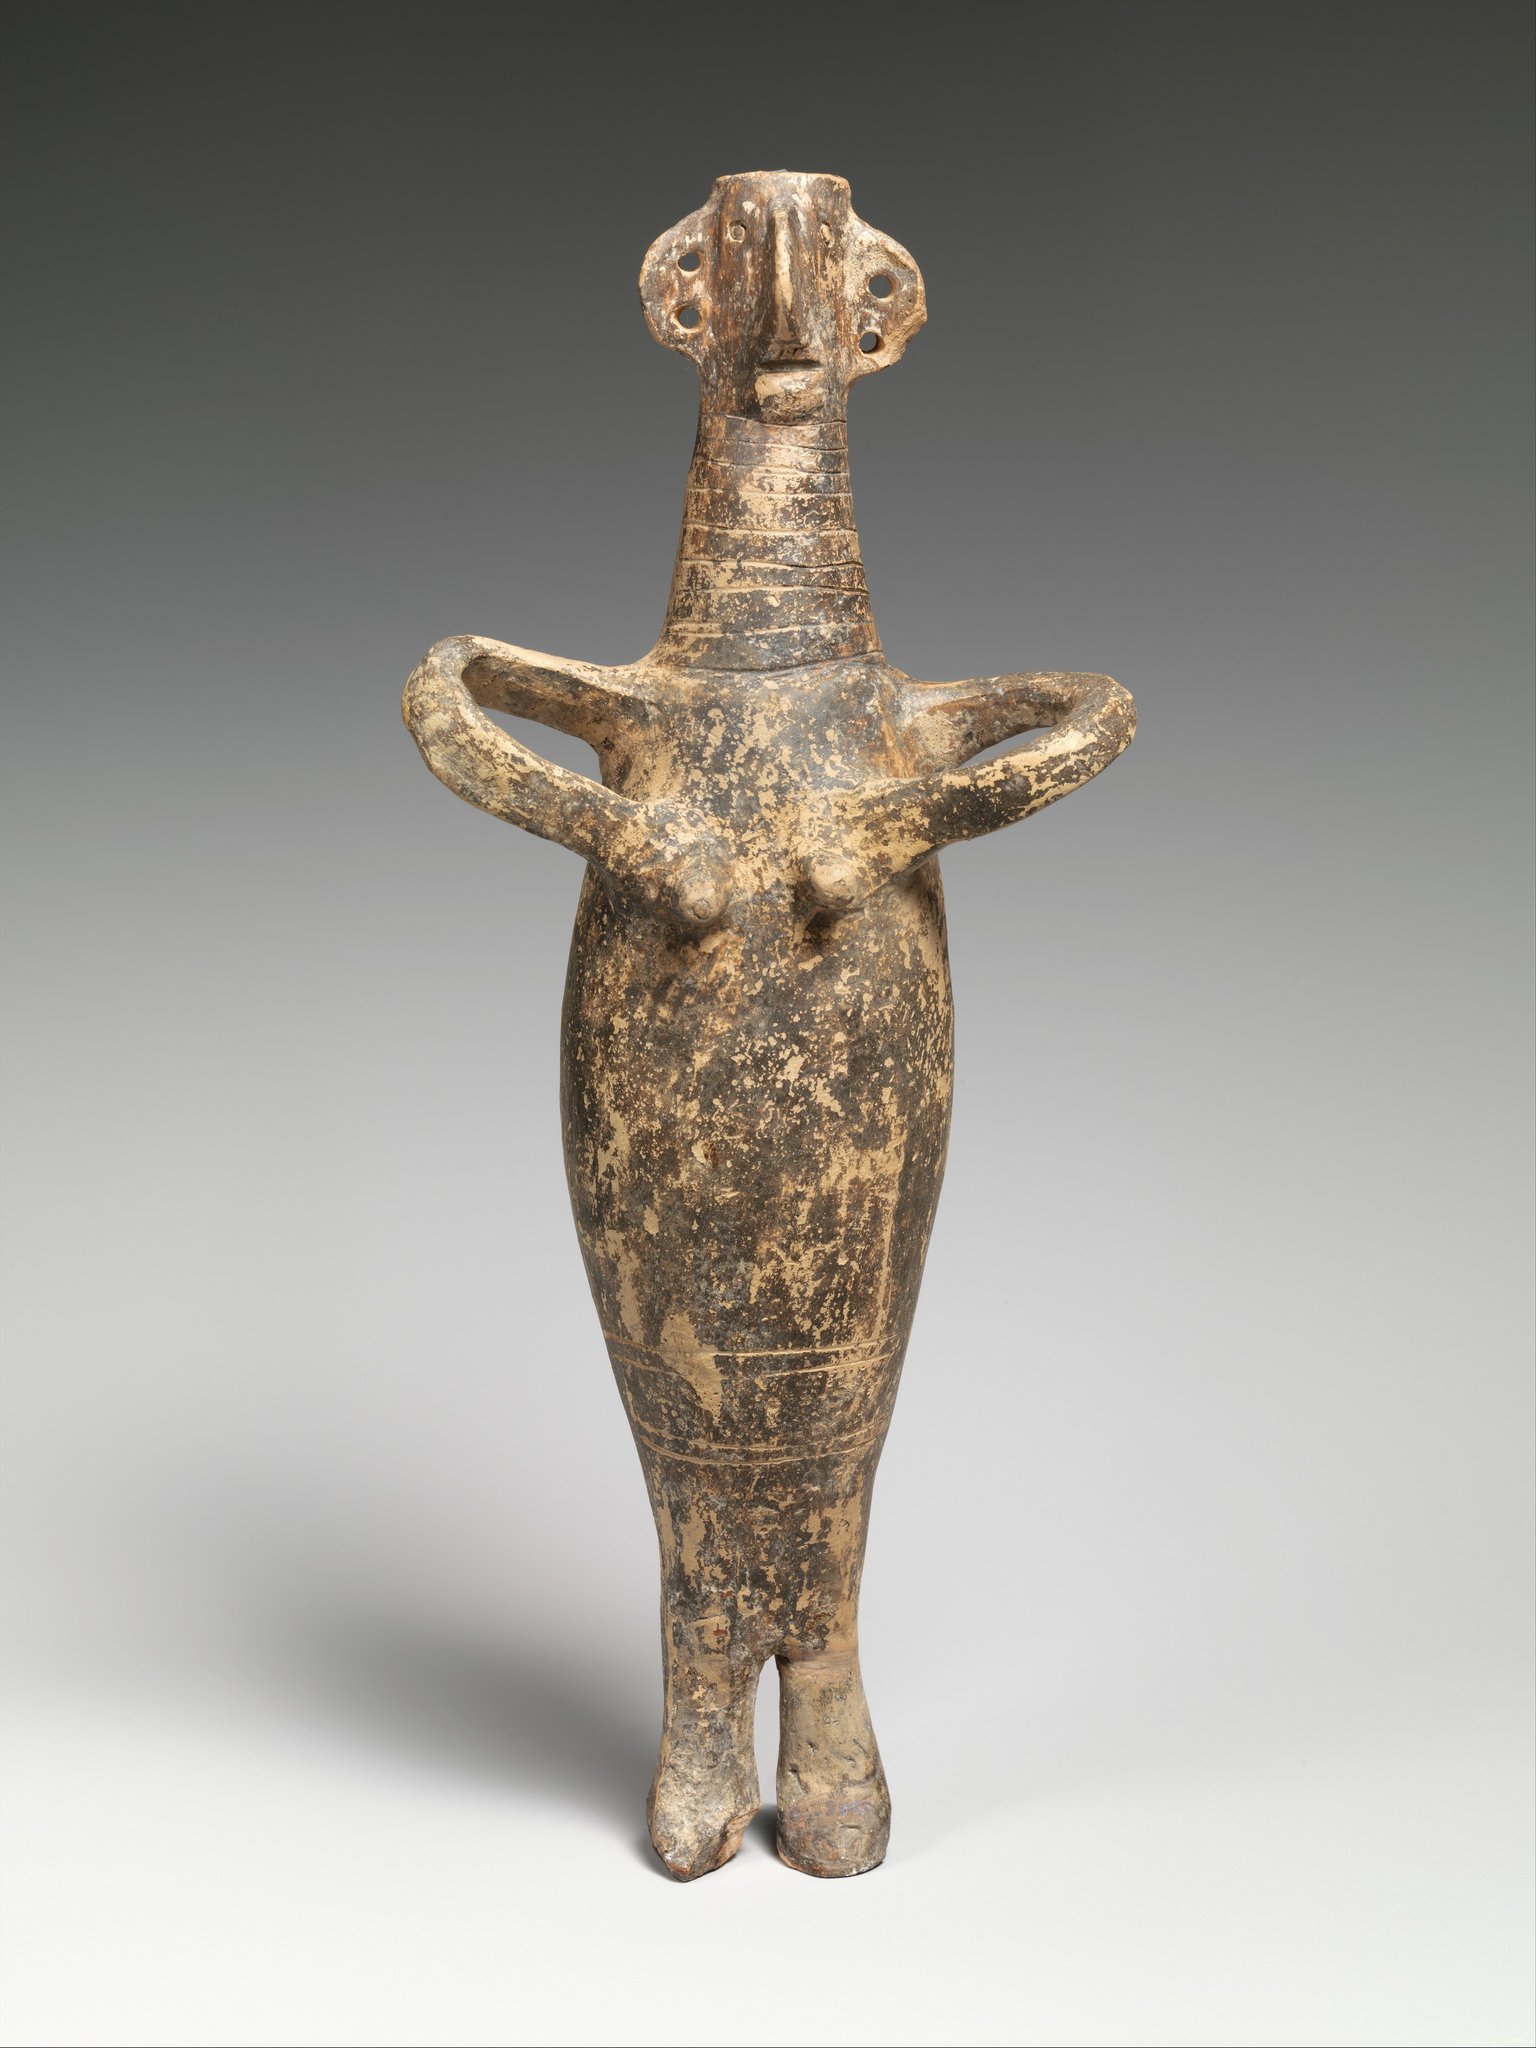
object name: statuette of a woman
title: Terracotta statuette of a woman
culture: cypriot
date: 1725-1450 BCE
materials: terracotta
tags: women